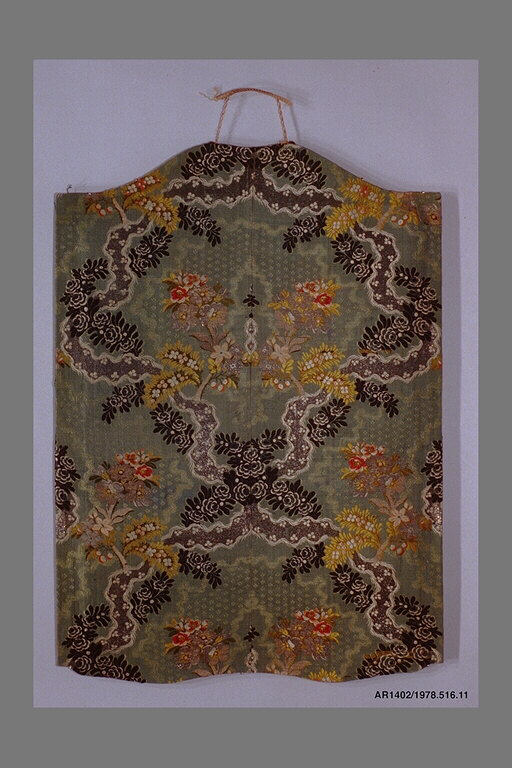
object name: panel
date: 1701-1800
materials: metal thread, silk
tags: flowers